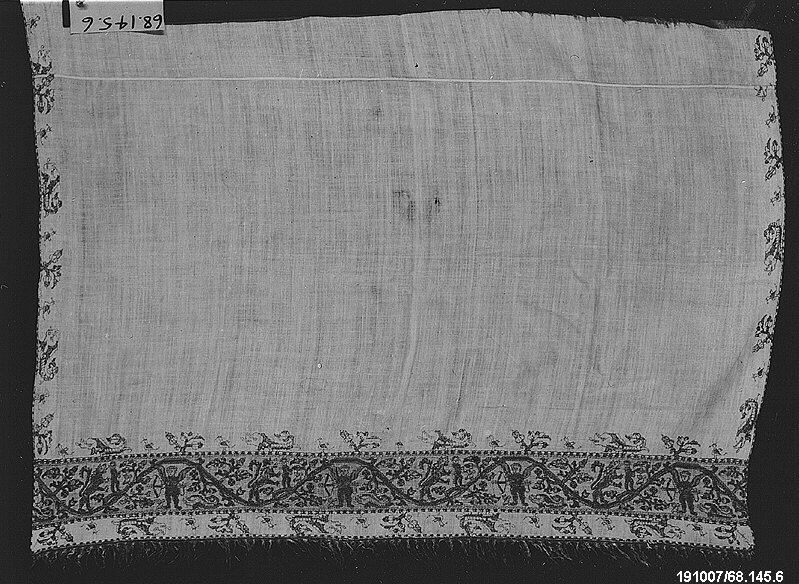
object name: towel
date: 1601-1633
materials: linen, silk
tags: cupid